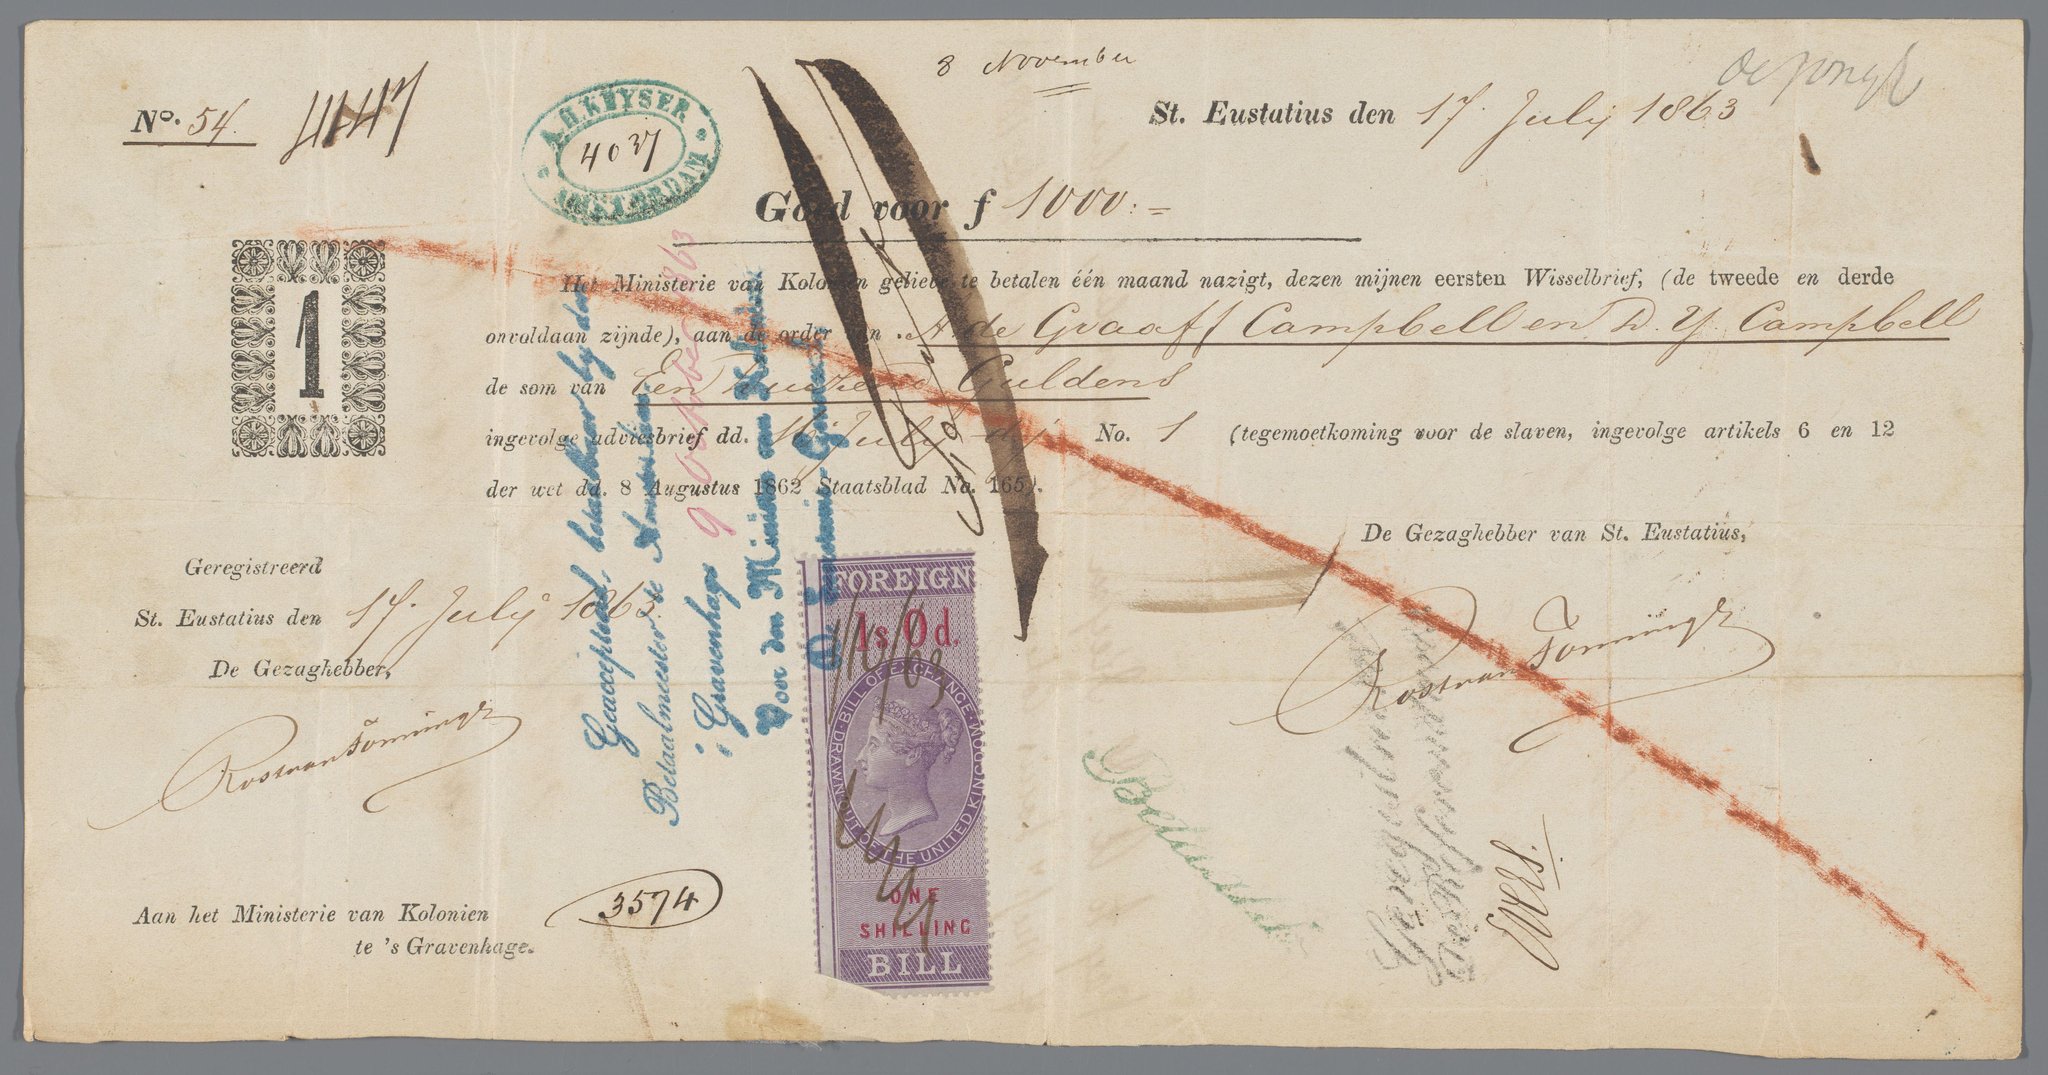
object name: ontvangstbewijs, kwitantie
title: Wisselbrief voor A. de Graaff Campbell en D.Y. Campbell, slaveneighouders op Sint Eustatius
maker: Anonymous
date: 1863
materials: ink, paper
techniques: printing, writing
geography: netherlands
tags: slavery; serfs and enslaved persons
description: Wisselbrief ter waarde van 1000 gulden ten name van A. de Graaff Campbell en D.Y. Campbell, 17 juli 1863. Wisselbrief uitgegeven aan slavenhouders op Sint Eustatius om deze bij de Emancipatie van 1863 te compenseren voor het vrij verklaren van de tot slaaf gemaakte mensen die zij tot hun bezit rekenden.